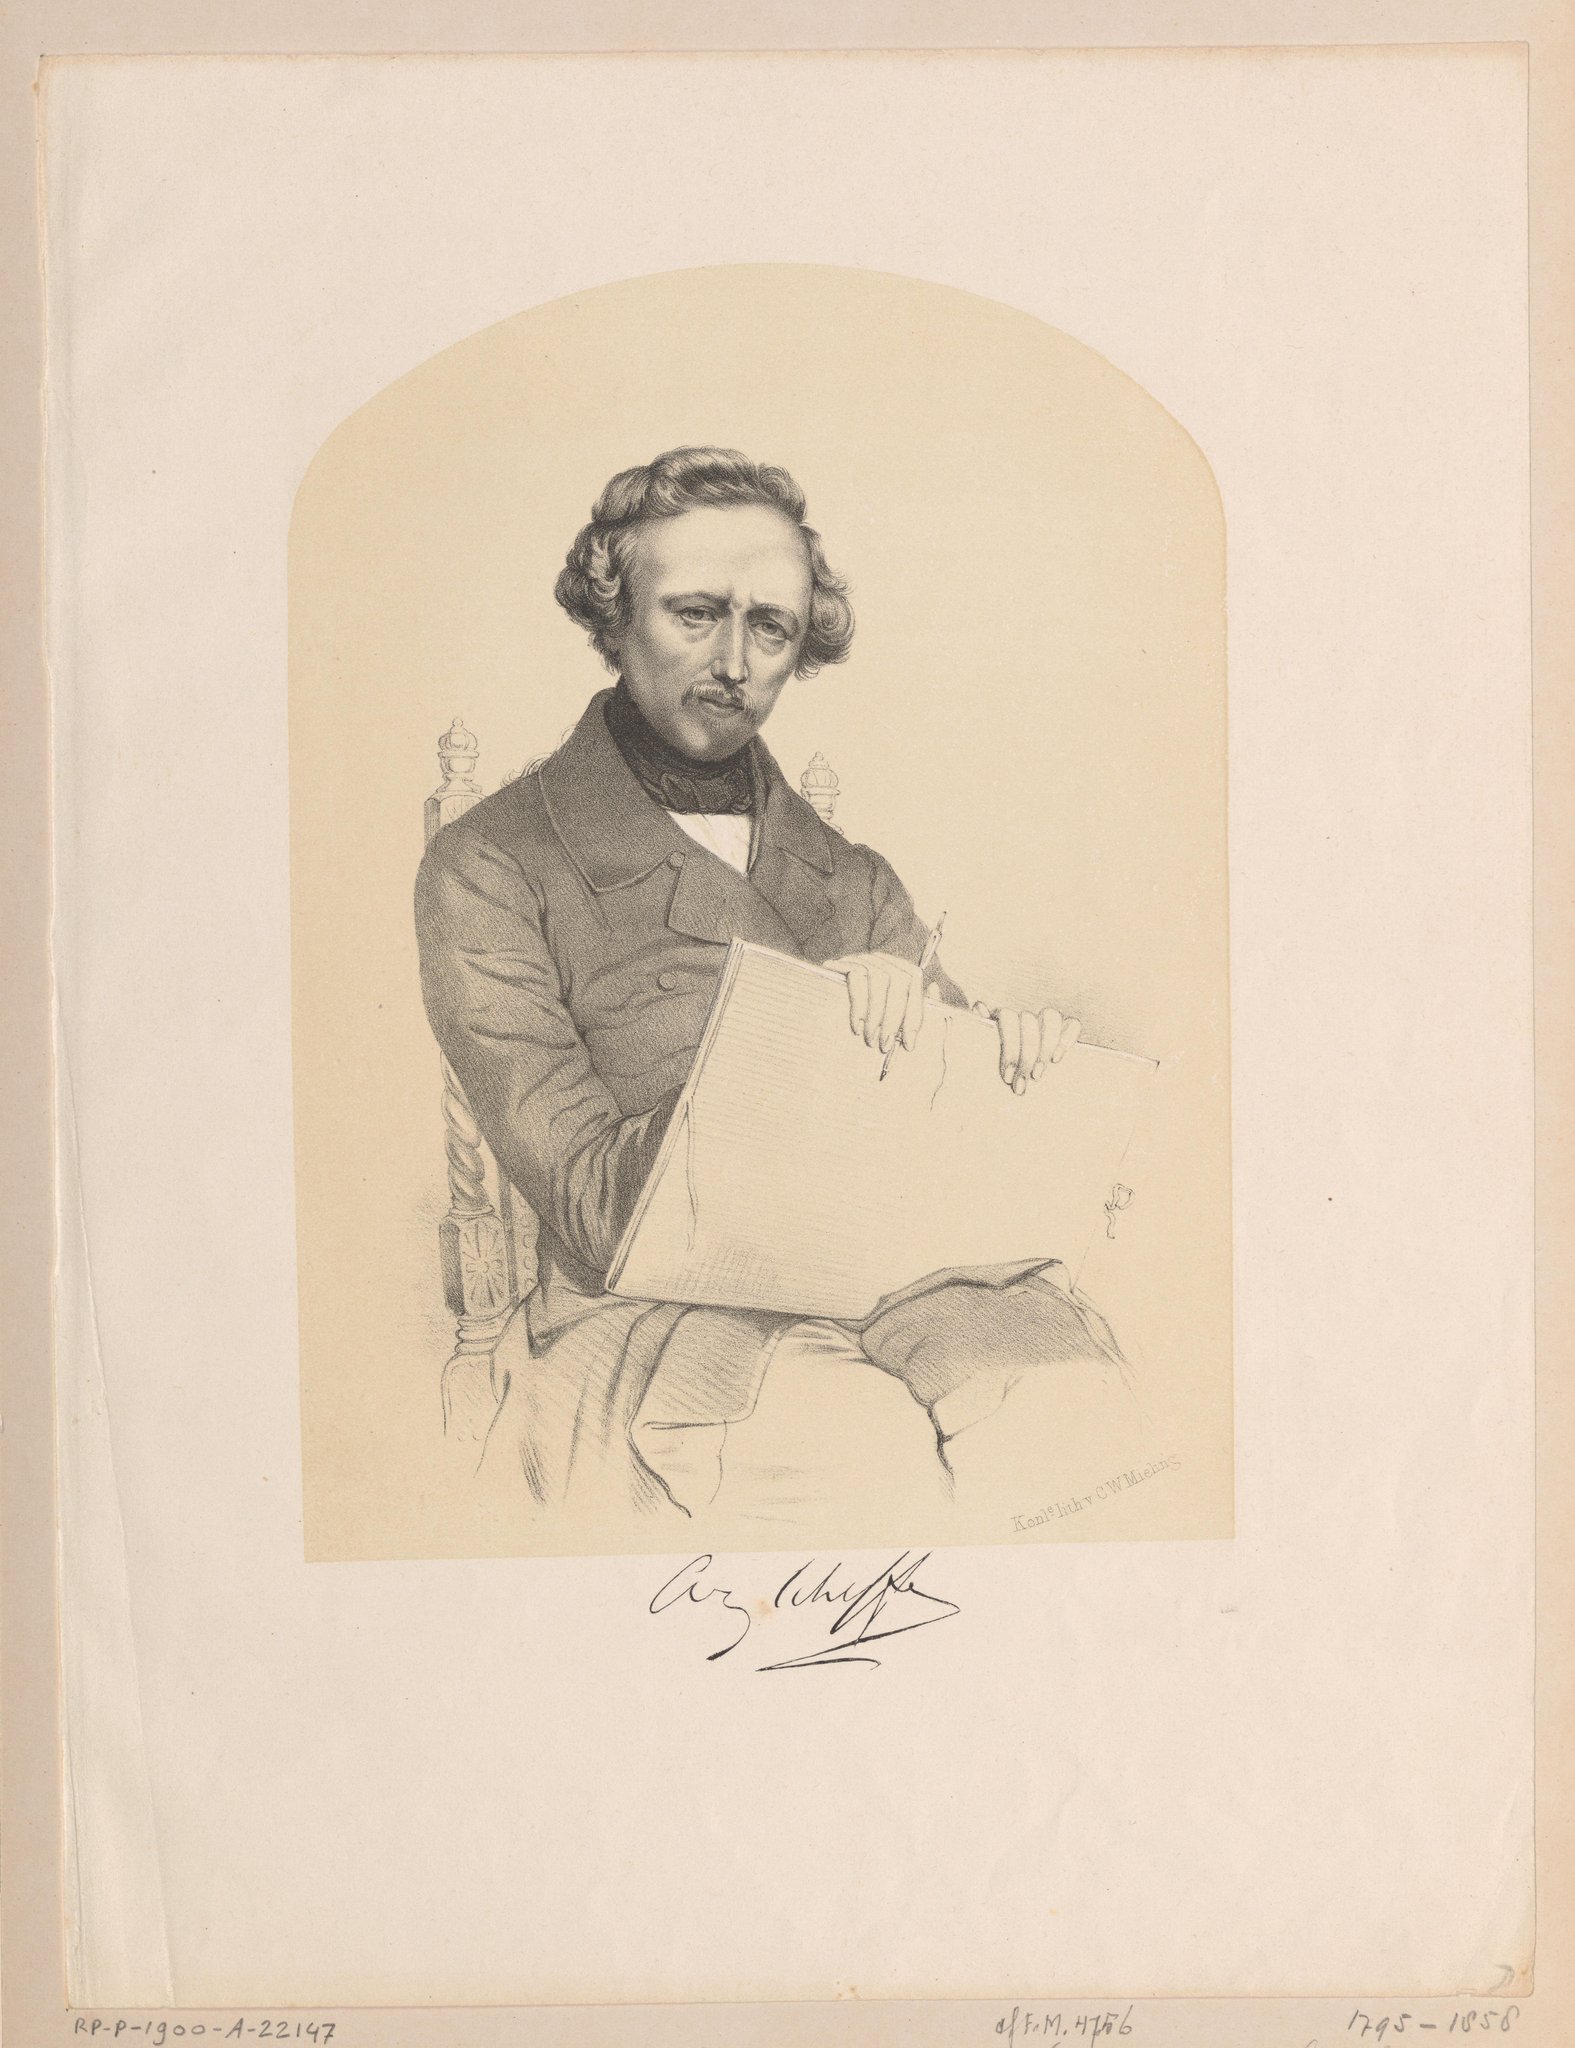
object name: print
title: Portret van Ary Scheffer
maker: Anonymous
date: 1847-1865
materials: paper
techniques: tone lithography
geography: the hague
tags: dordrecht, painter, print maker, draughtsman, sculptor, ary scheffer, historical persons, portrait, self-portrait of painter, tools, implements of painter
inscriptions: inscription: ‘D’, collector's mark: Lugt 2228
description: Zittend op een stoel met tekenmap en pen in zijn hand.